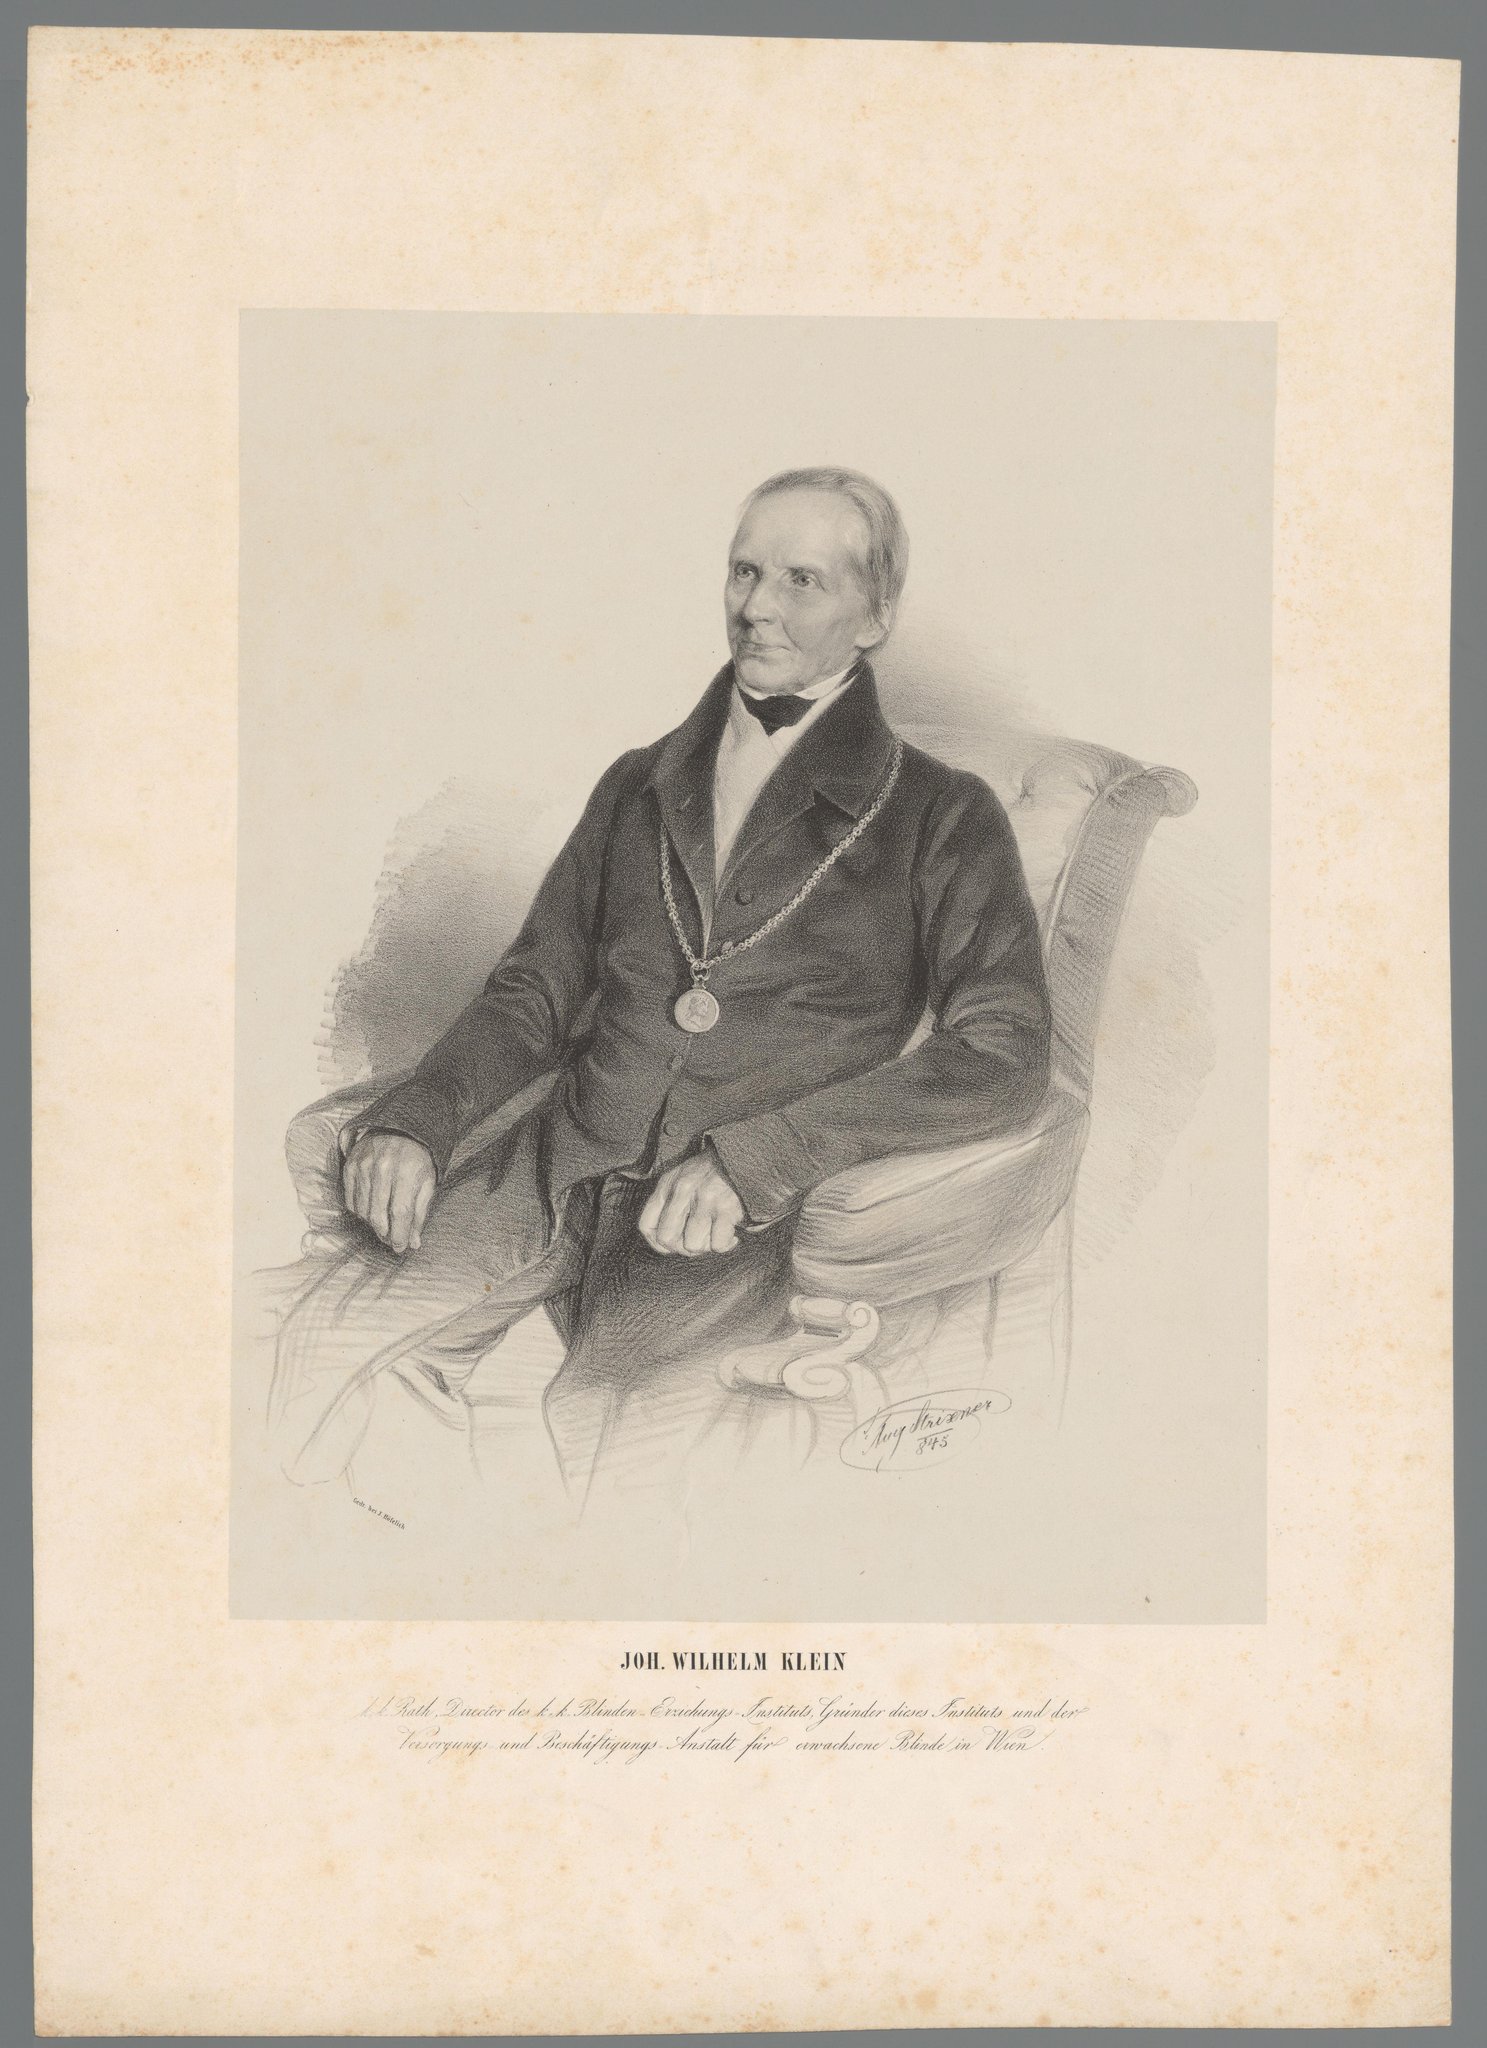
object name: print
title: Portret van Johann Wilhelm Klein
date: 1845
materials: paper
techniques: lithograph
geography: vienna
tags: armchair, seat, adult man, historical persons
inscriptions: collector's mark: Lugt 2228